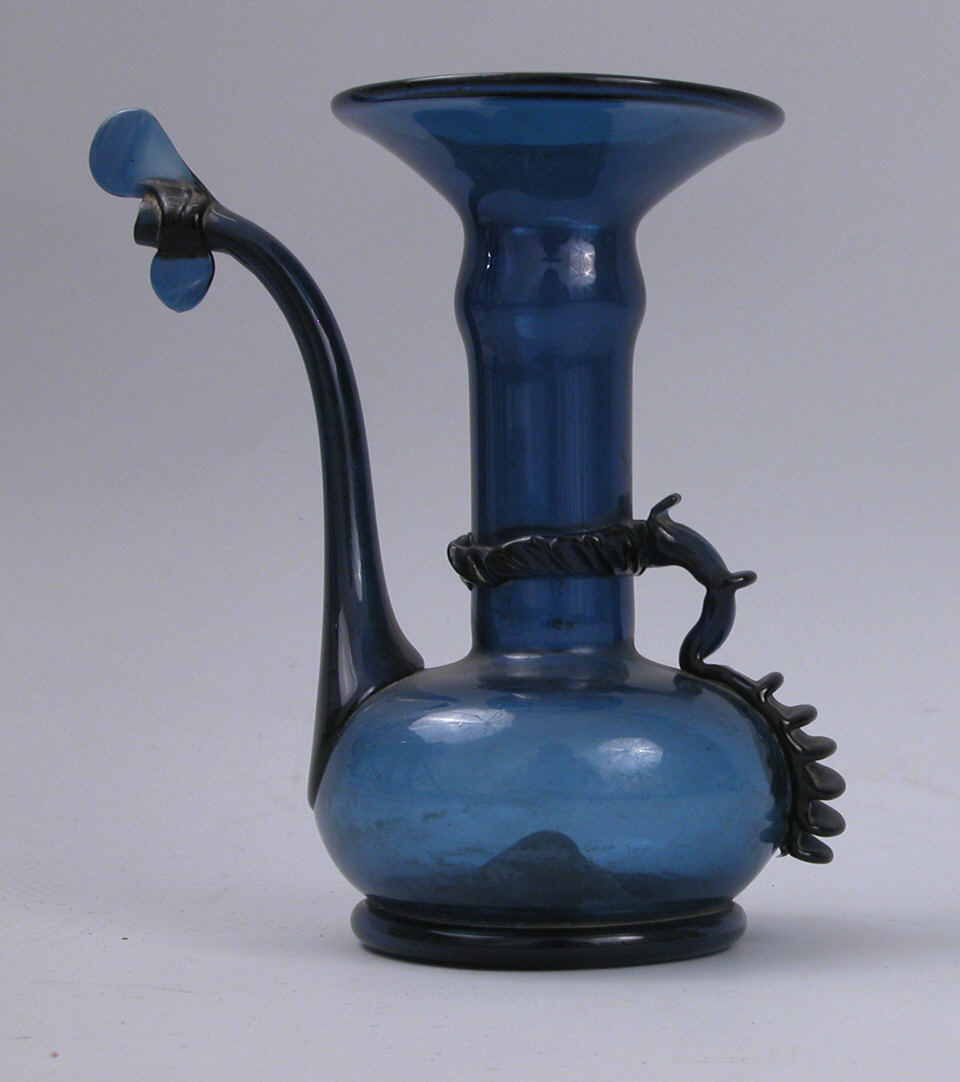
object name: ewer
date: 1701-1900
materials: glass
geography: iran